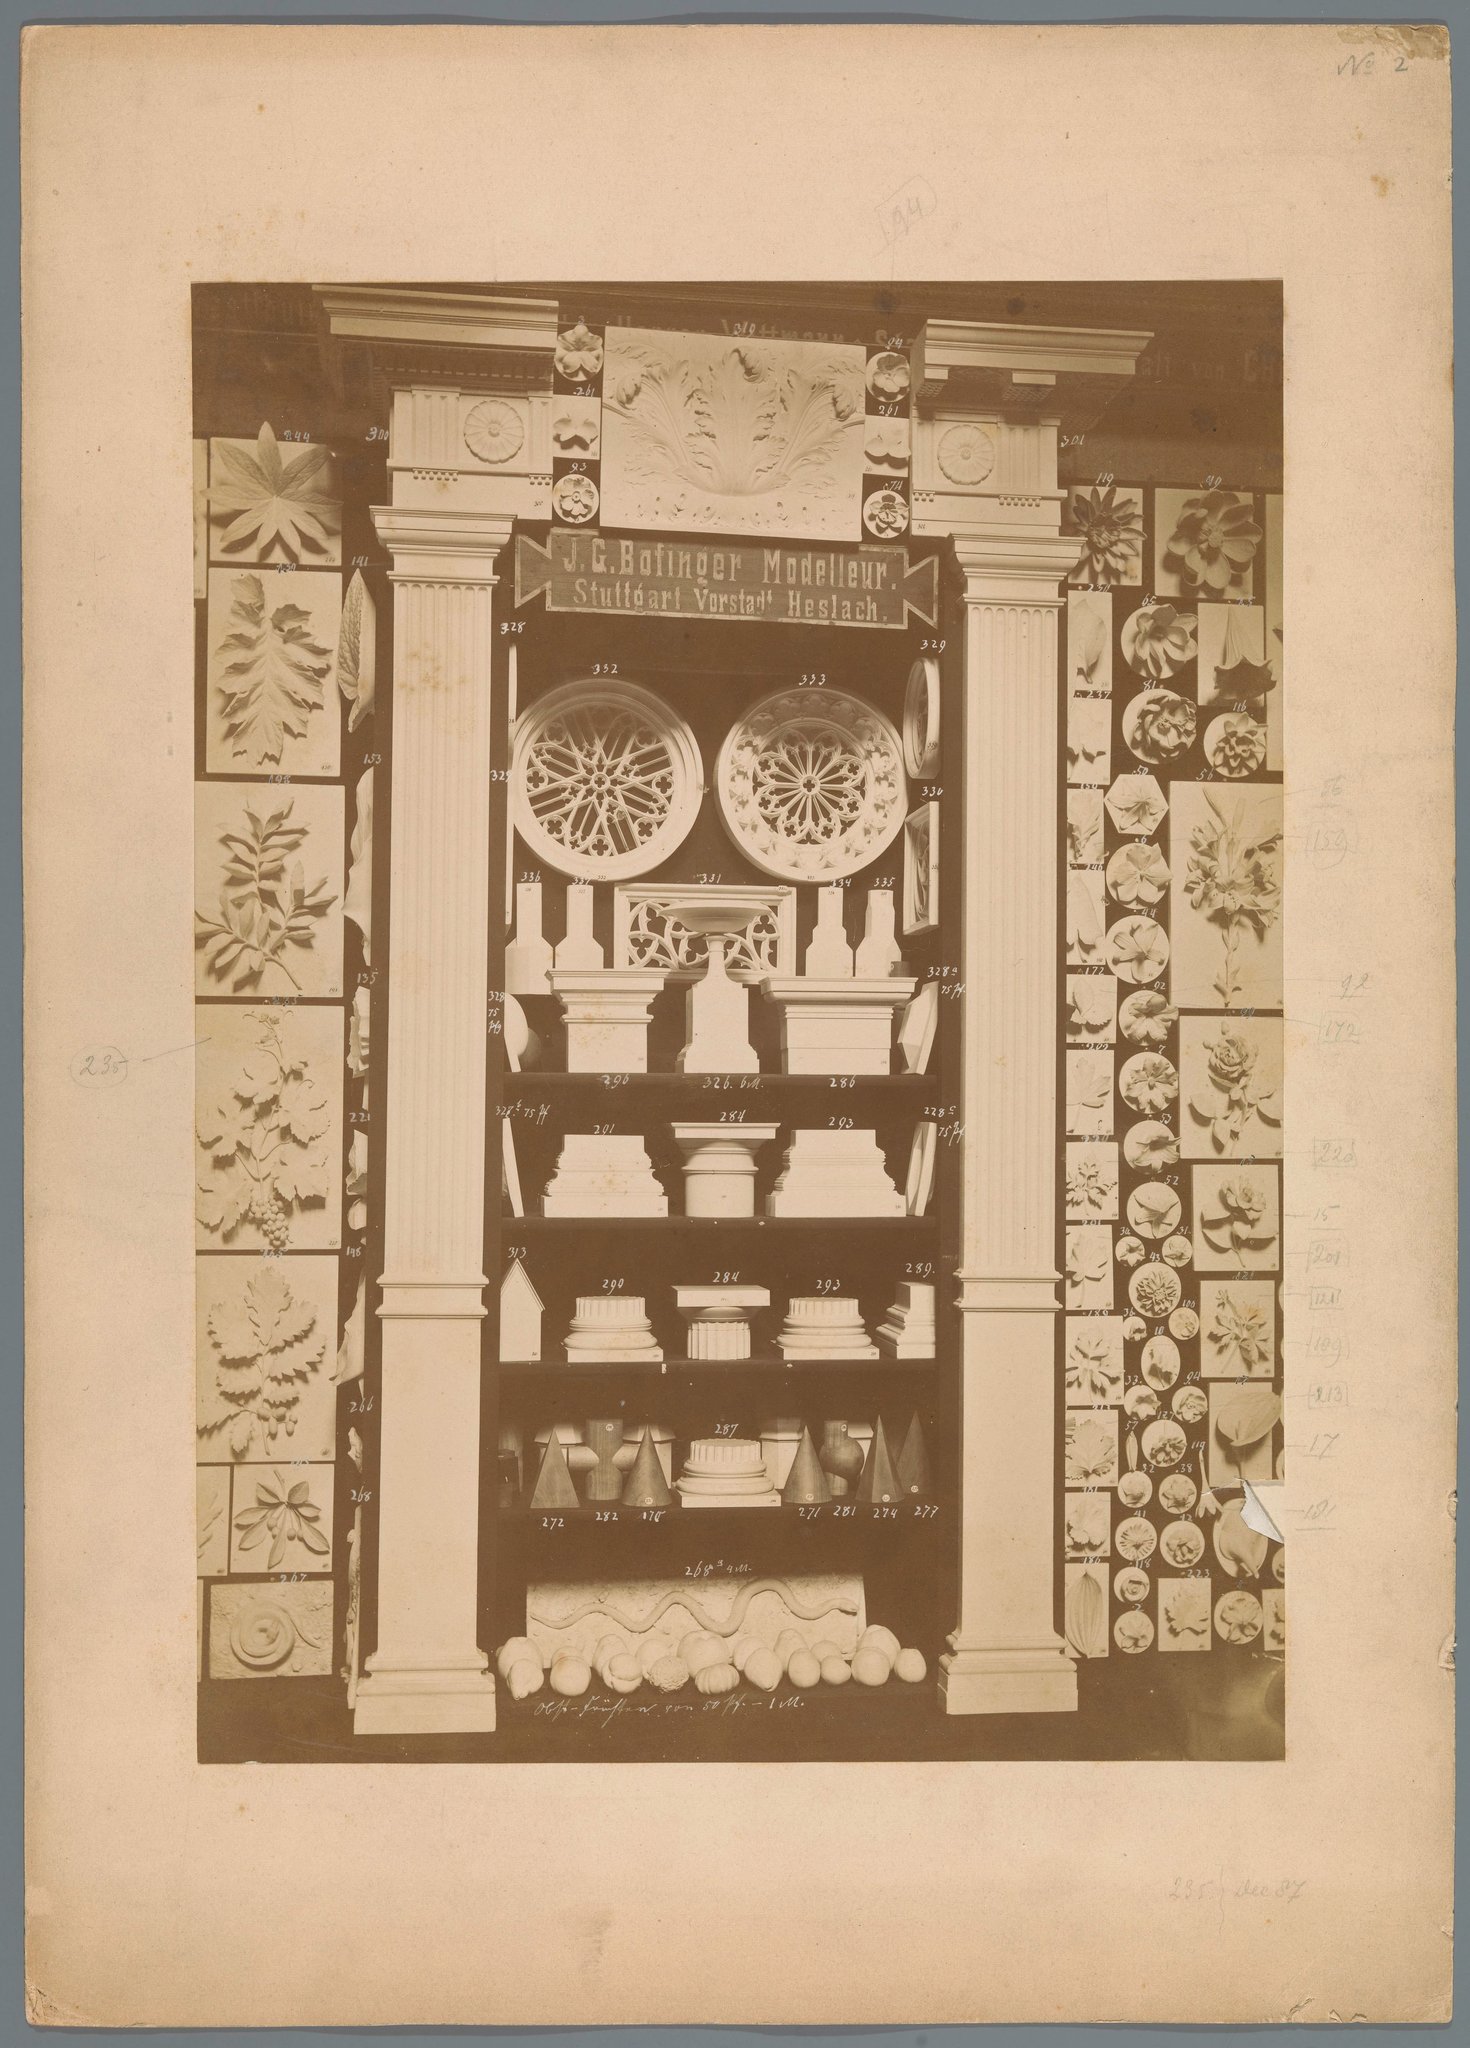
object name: photograph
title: Opstelling van pleistermodellen door J.G. Bofinger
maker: Anonymous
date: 1887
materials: cardboard, photographic support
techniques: albumen print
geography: europe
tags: ornaments ~ art, column, pillar ~ architecture, piece of sculpture, reproduction of a piece of sculpture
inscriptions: number, number: ‘No. 2’